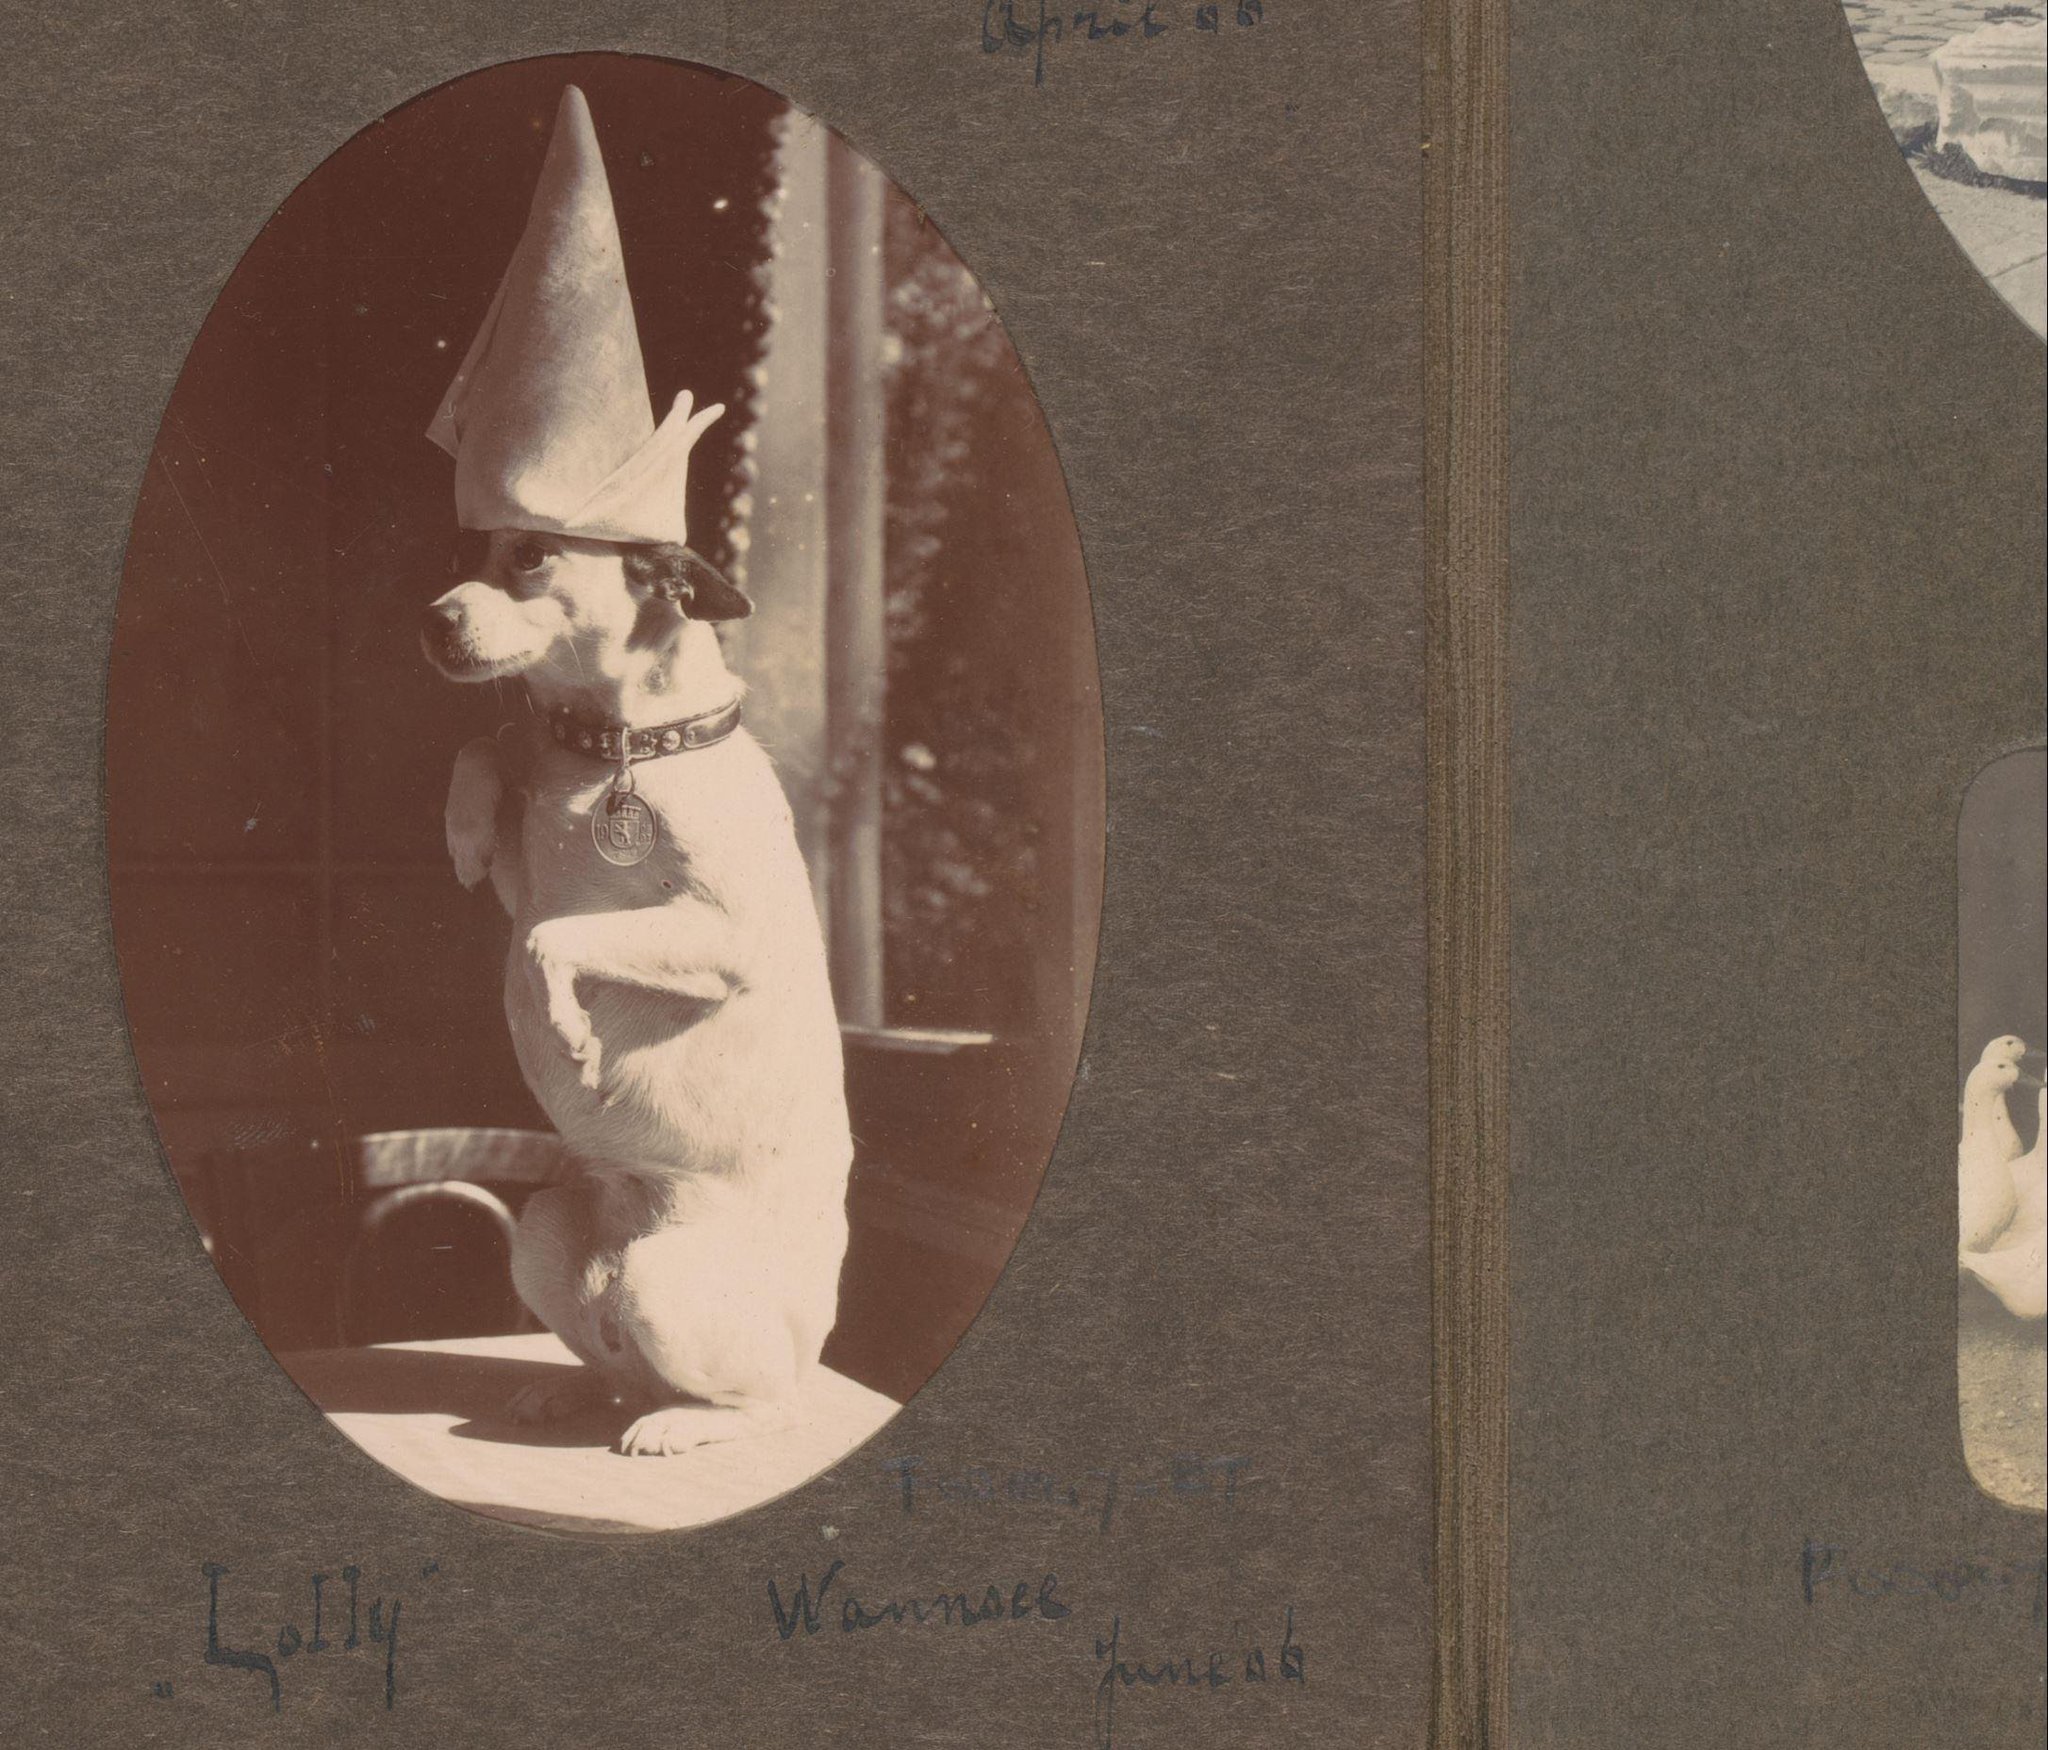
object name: album leaf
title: Opzittende hond genaamd Lolly, met puntmuts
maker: Anonymous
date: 1906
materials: cardboard, paper, photographic support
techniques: gelatin silver print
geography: berlin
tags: training of performing dog, head-gear: cap, dog, berlin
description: Onderdeel van Reisalbum van een Nederlandse familie met bezienswaardigheden in Europa, Egypte en New York.